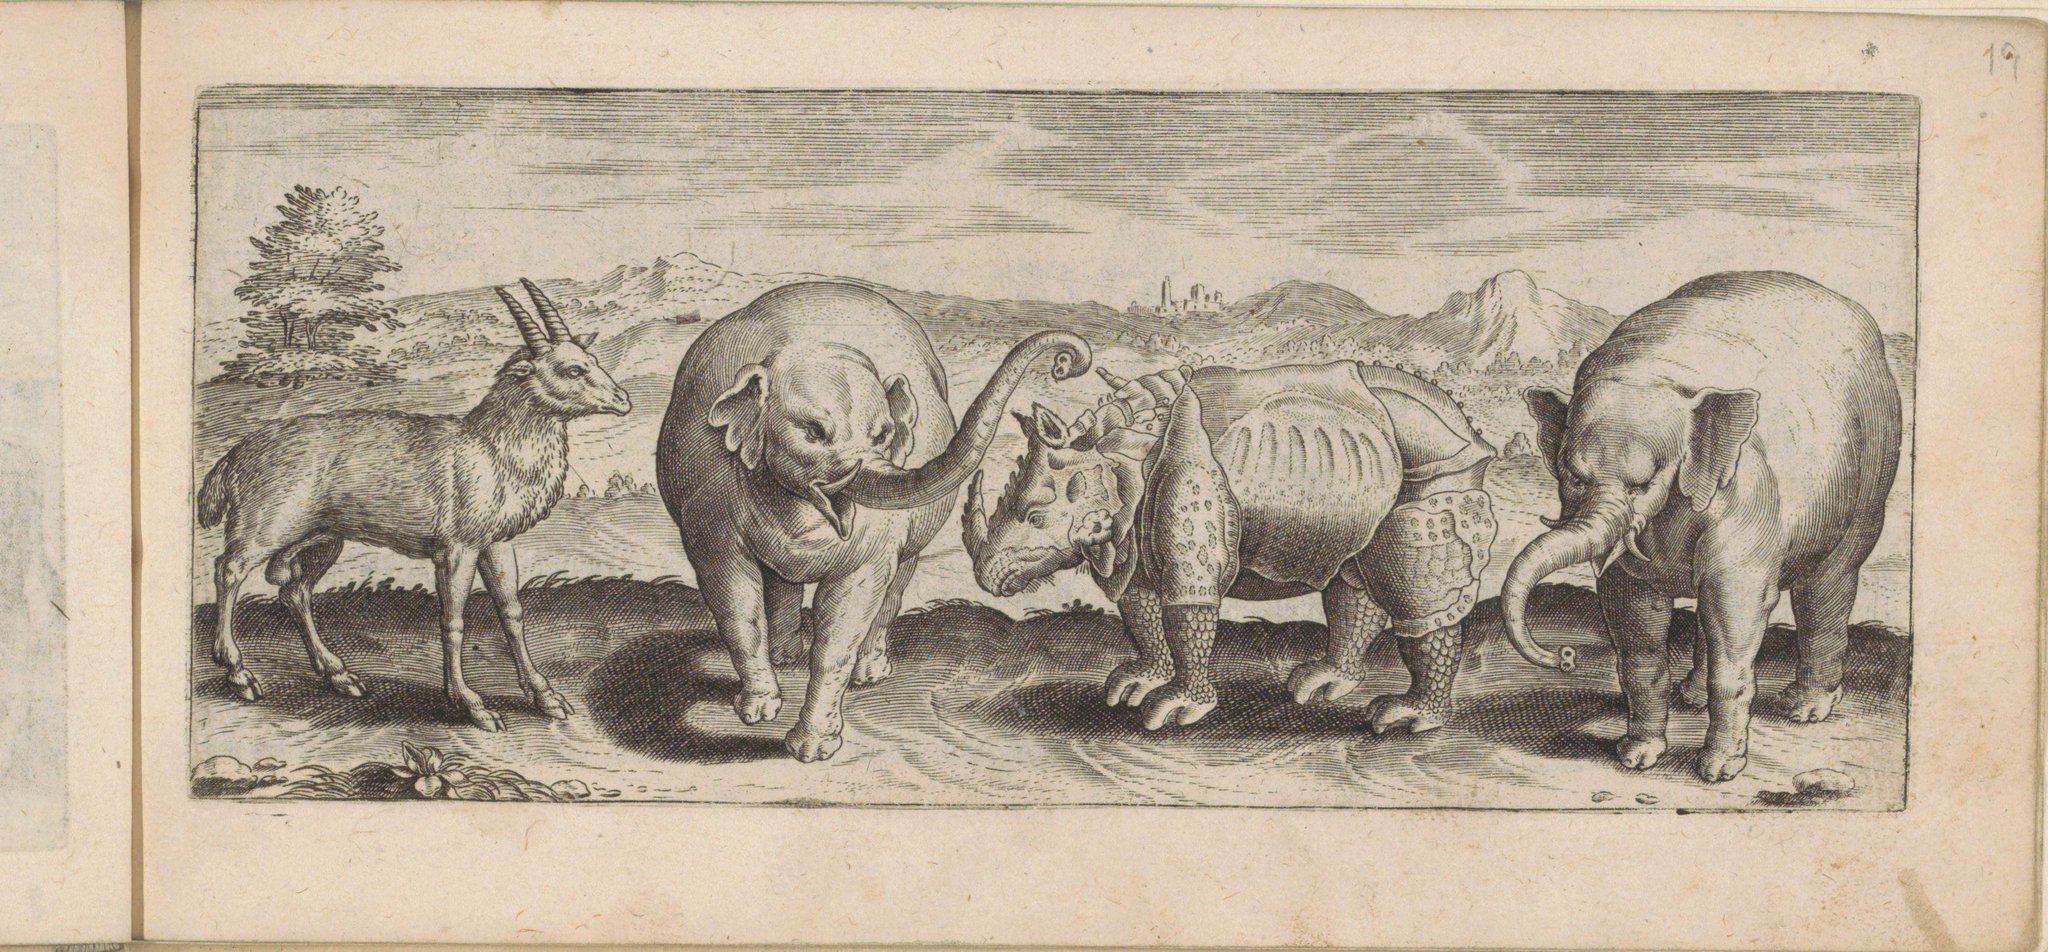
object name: album leaf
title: Gazelle, olifanten en neushoorn in een landschap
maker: eduwart van hoeswinckel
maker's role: publisher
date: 1583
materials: paper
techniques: engraving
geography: antwerp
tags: landscapes in the temperate zone, hoofed animals: rhinoceros, hoofed animals: gazelle, trunked animals: elephant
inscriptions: collector's mark: Lugt 2760, collector's mark: Lugt 2228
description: De neushoorn is waarschijnlijk gekopieerd naar de illustratie in Conrad Gesners' 'Historia animalium', 1551-1558, die op zijn beurt gebaseerd is op de houtsnede van een neushoorn door Albrecht Dürer.